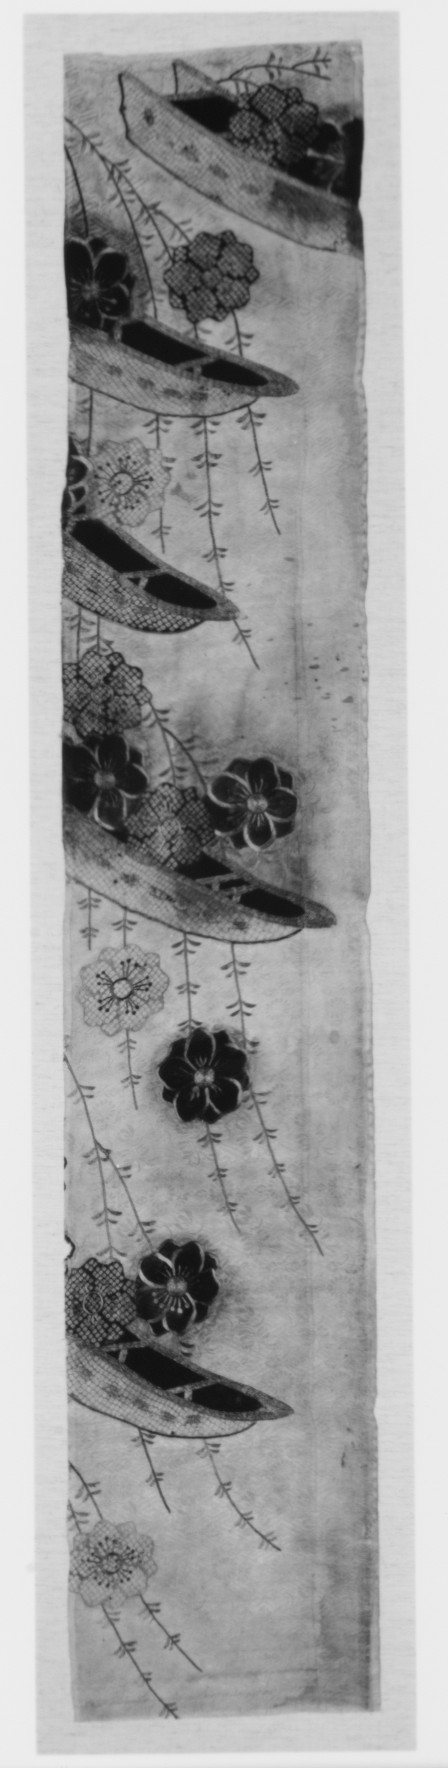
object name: piece from a kosode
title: Kosode Fragment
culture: japanese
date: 1615-1868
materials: textile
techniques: damask